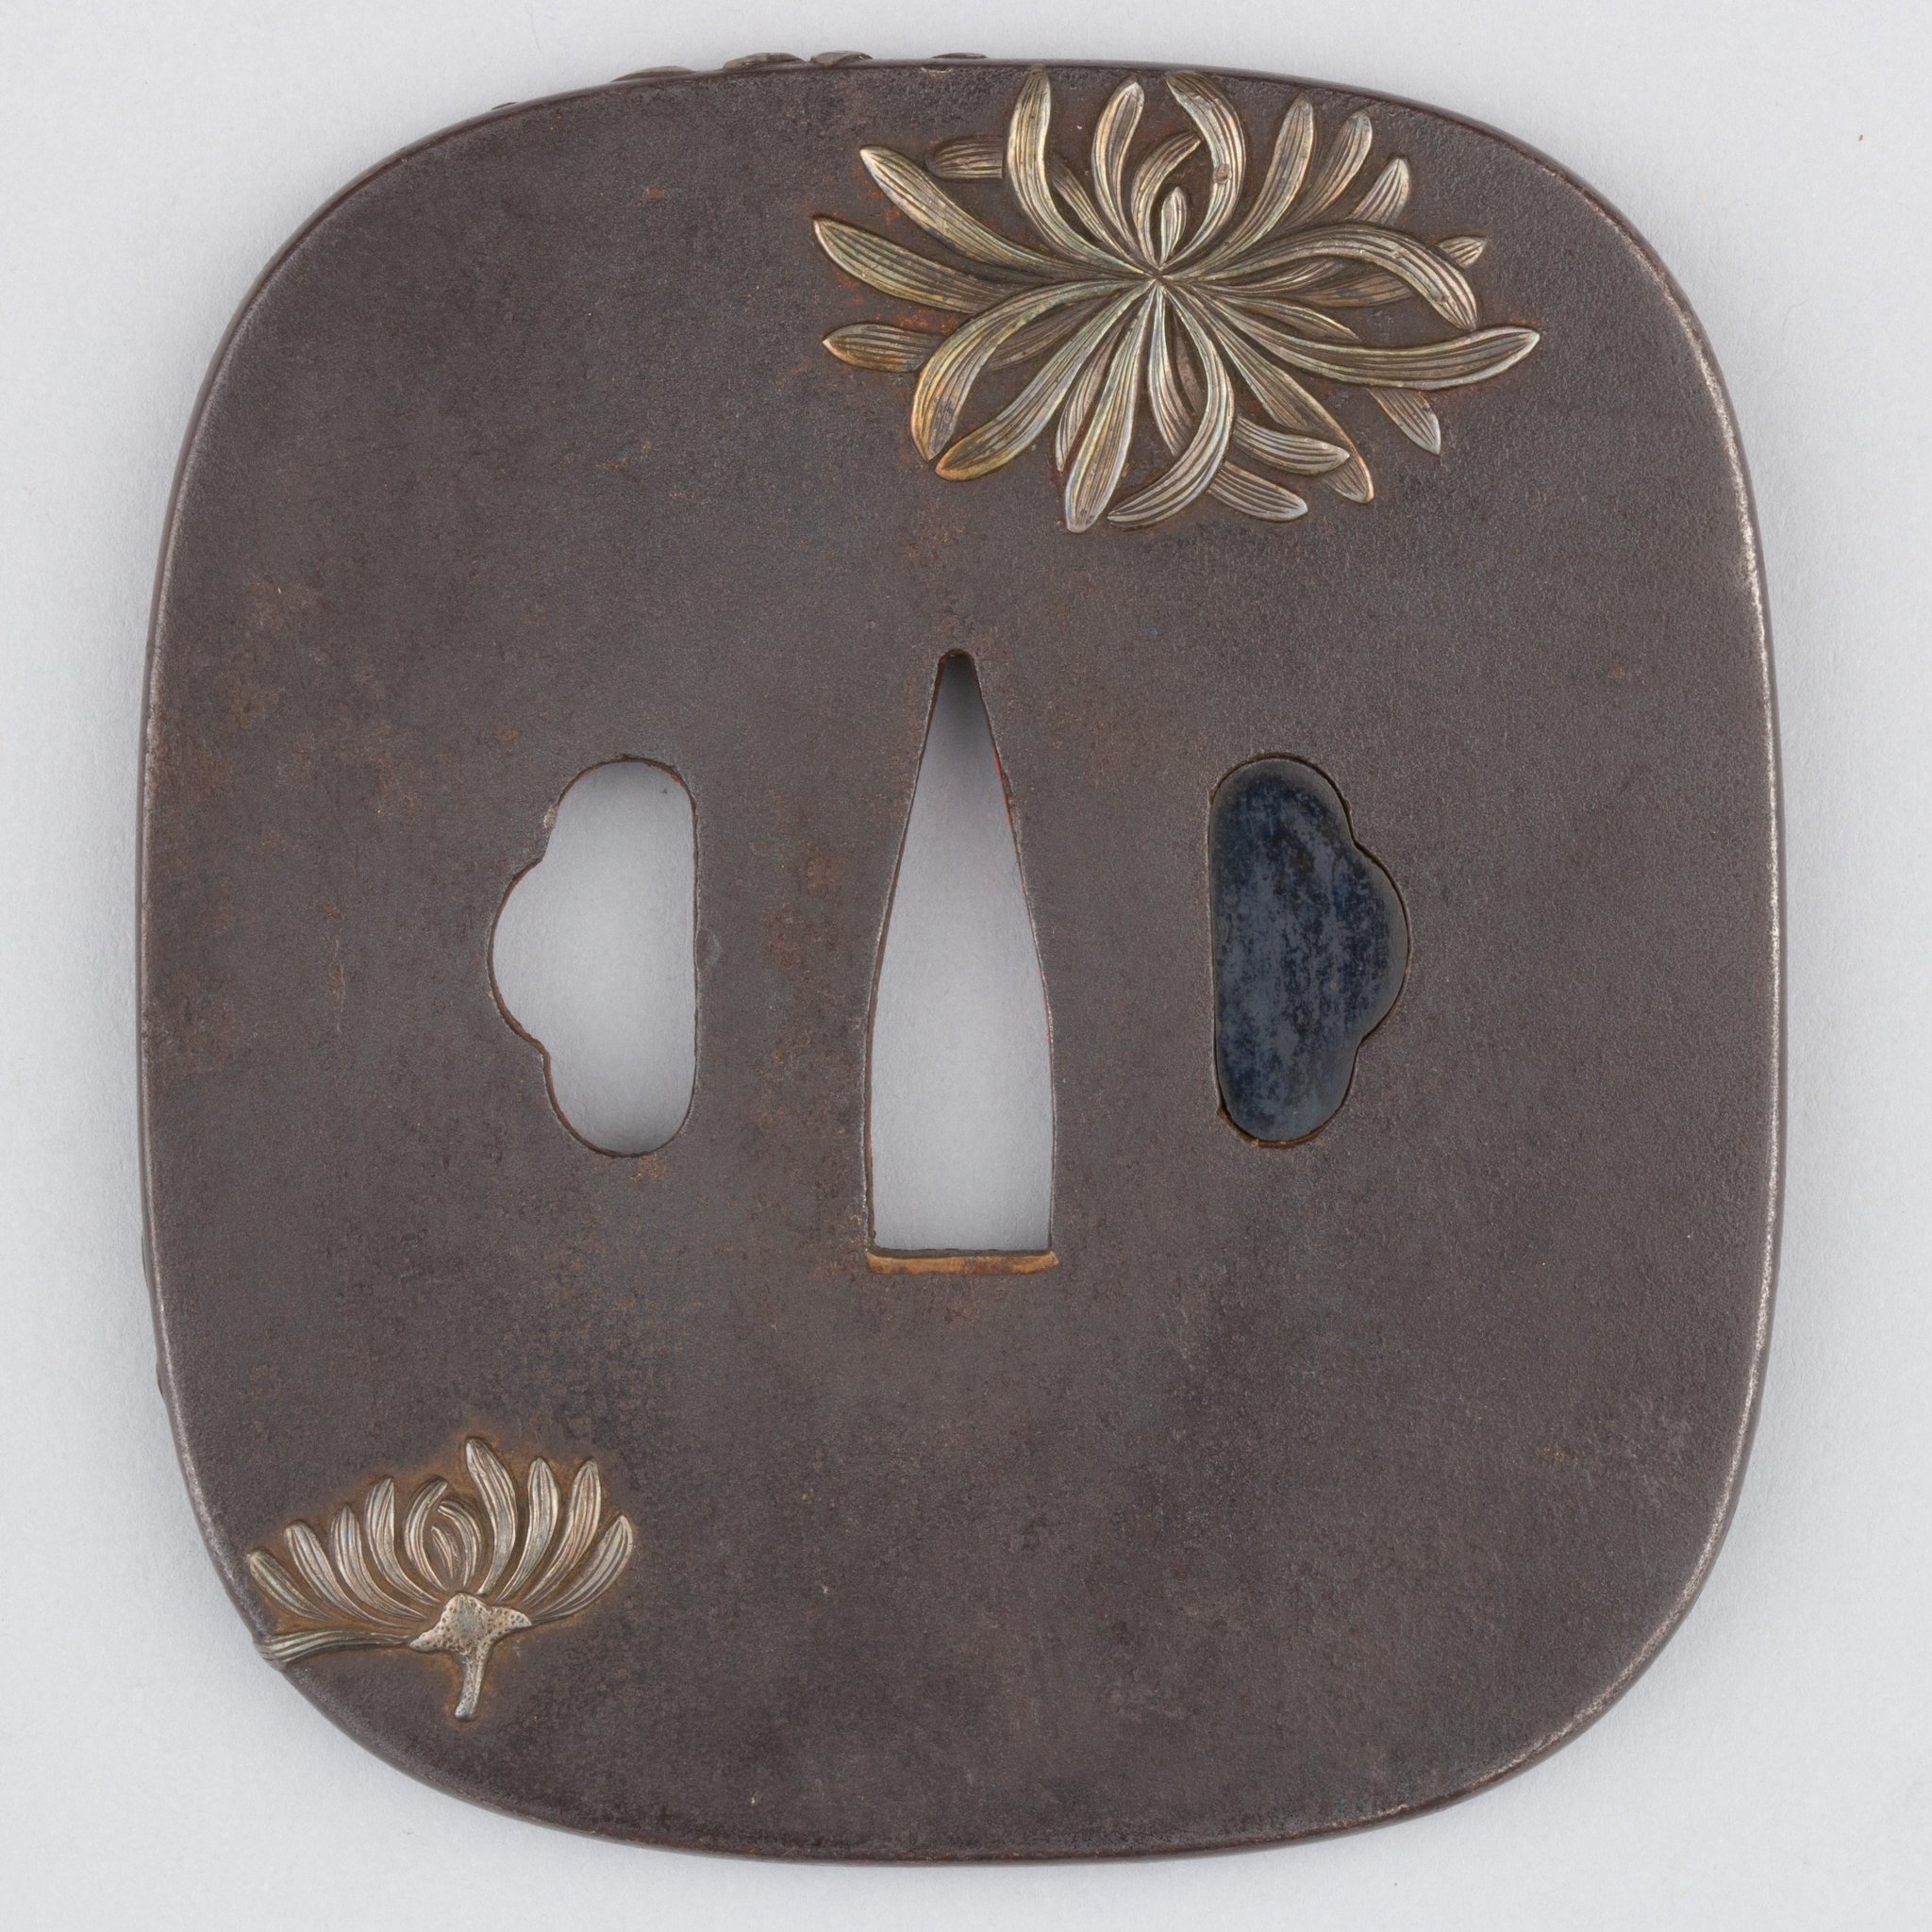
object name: sword guard tsuba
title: Sword Guard (Tsuba)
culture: japanese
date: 1615-1868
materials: copper, iron, silver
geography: japan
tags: flowers